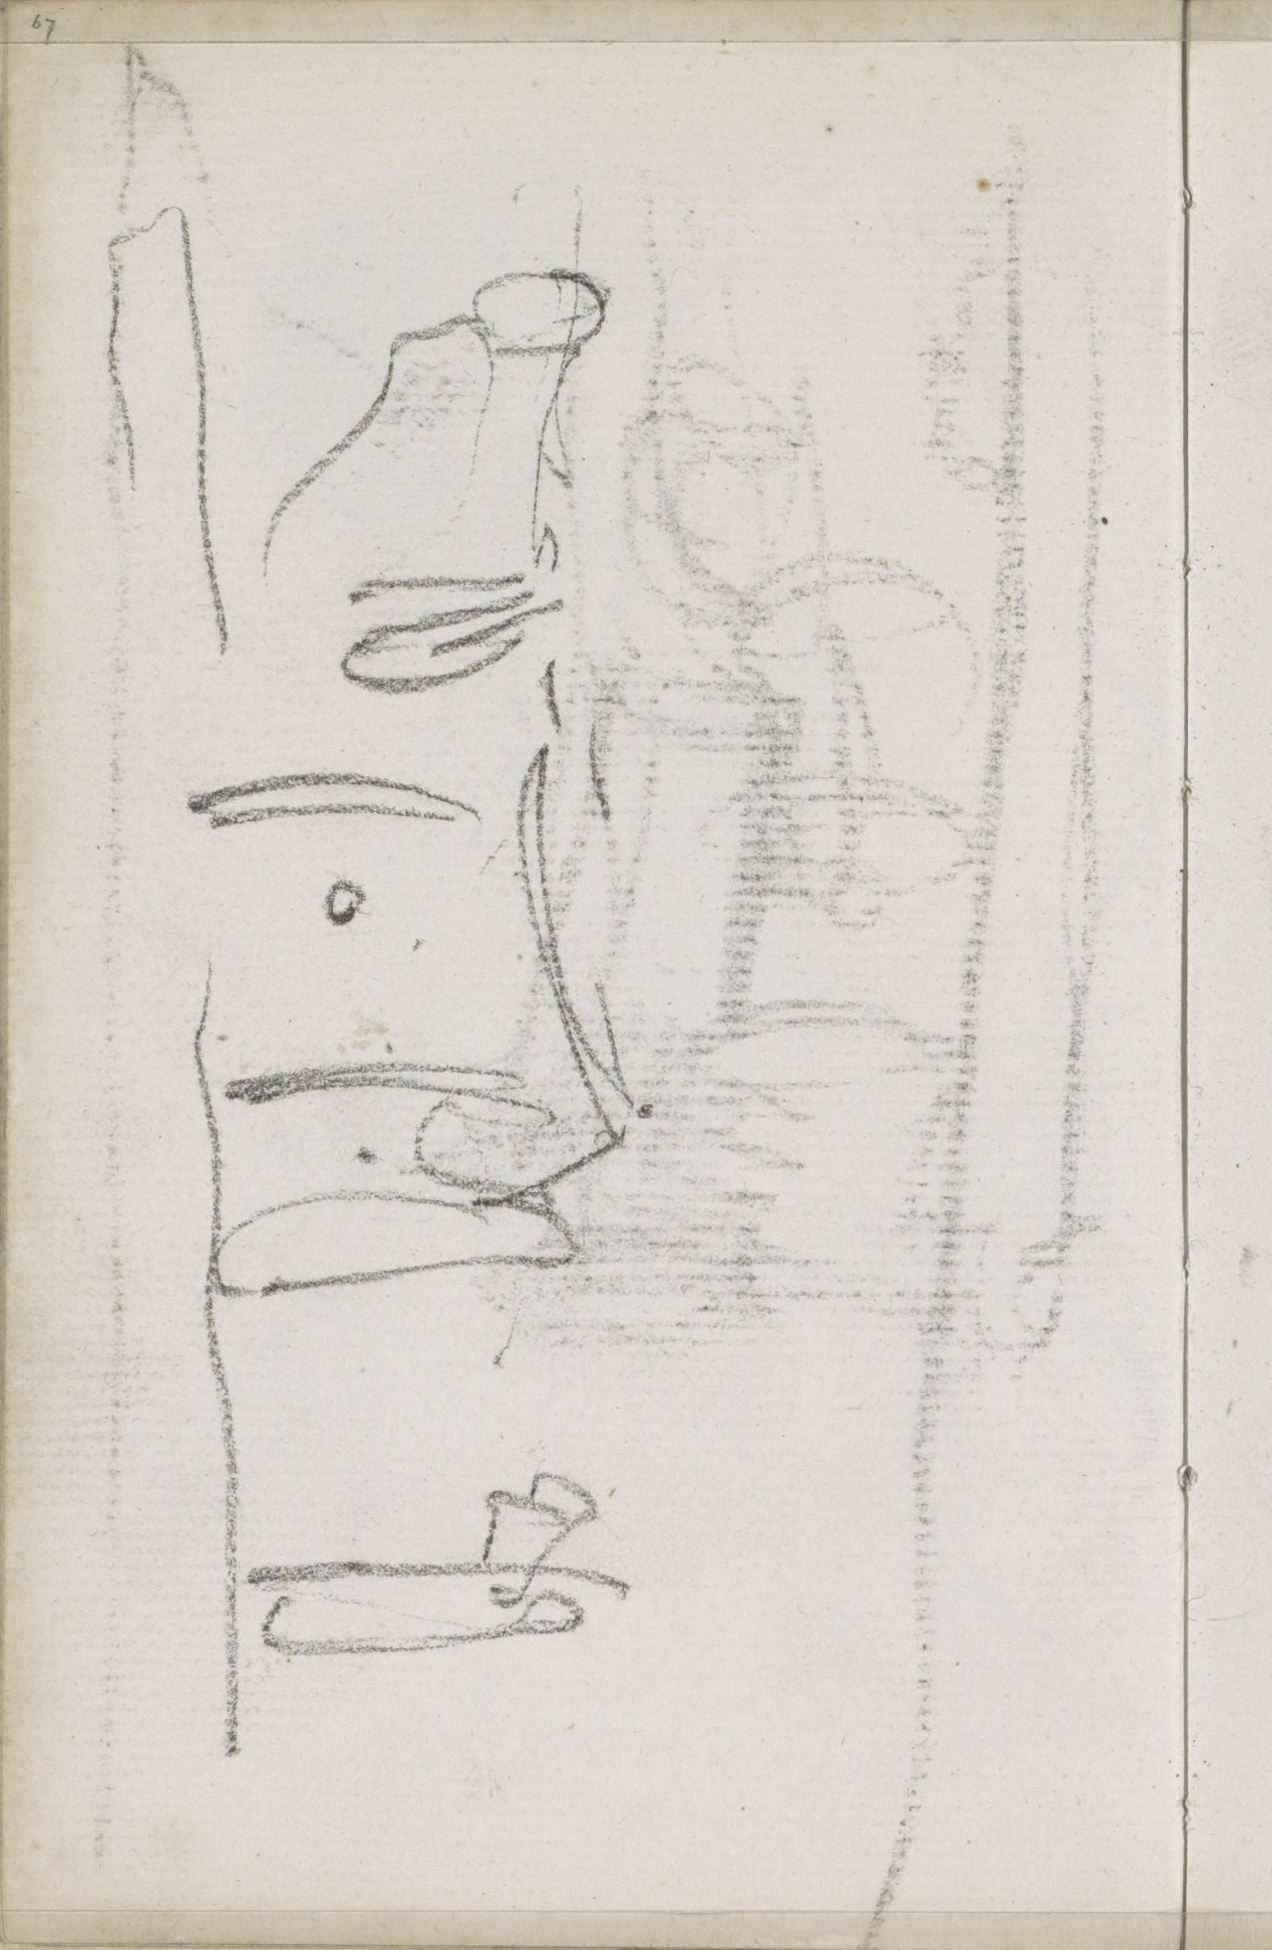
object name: sketchbook leaf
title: Kar of ploeg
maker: george hendrik breitner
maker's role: draughtsman, painter, print maker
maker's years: 1857-1923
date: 1884-1886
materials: chalk, paper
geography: drenthe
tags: agricultural implements: plough, (farm) wagon, freight wagon, cart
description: Pagina 67 uit een schetsboek met 67 bladen vervaardigd in Drenthe.